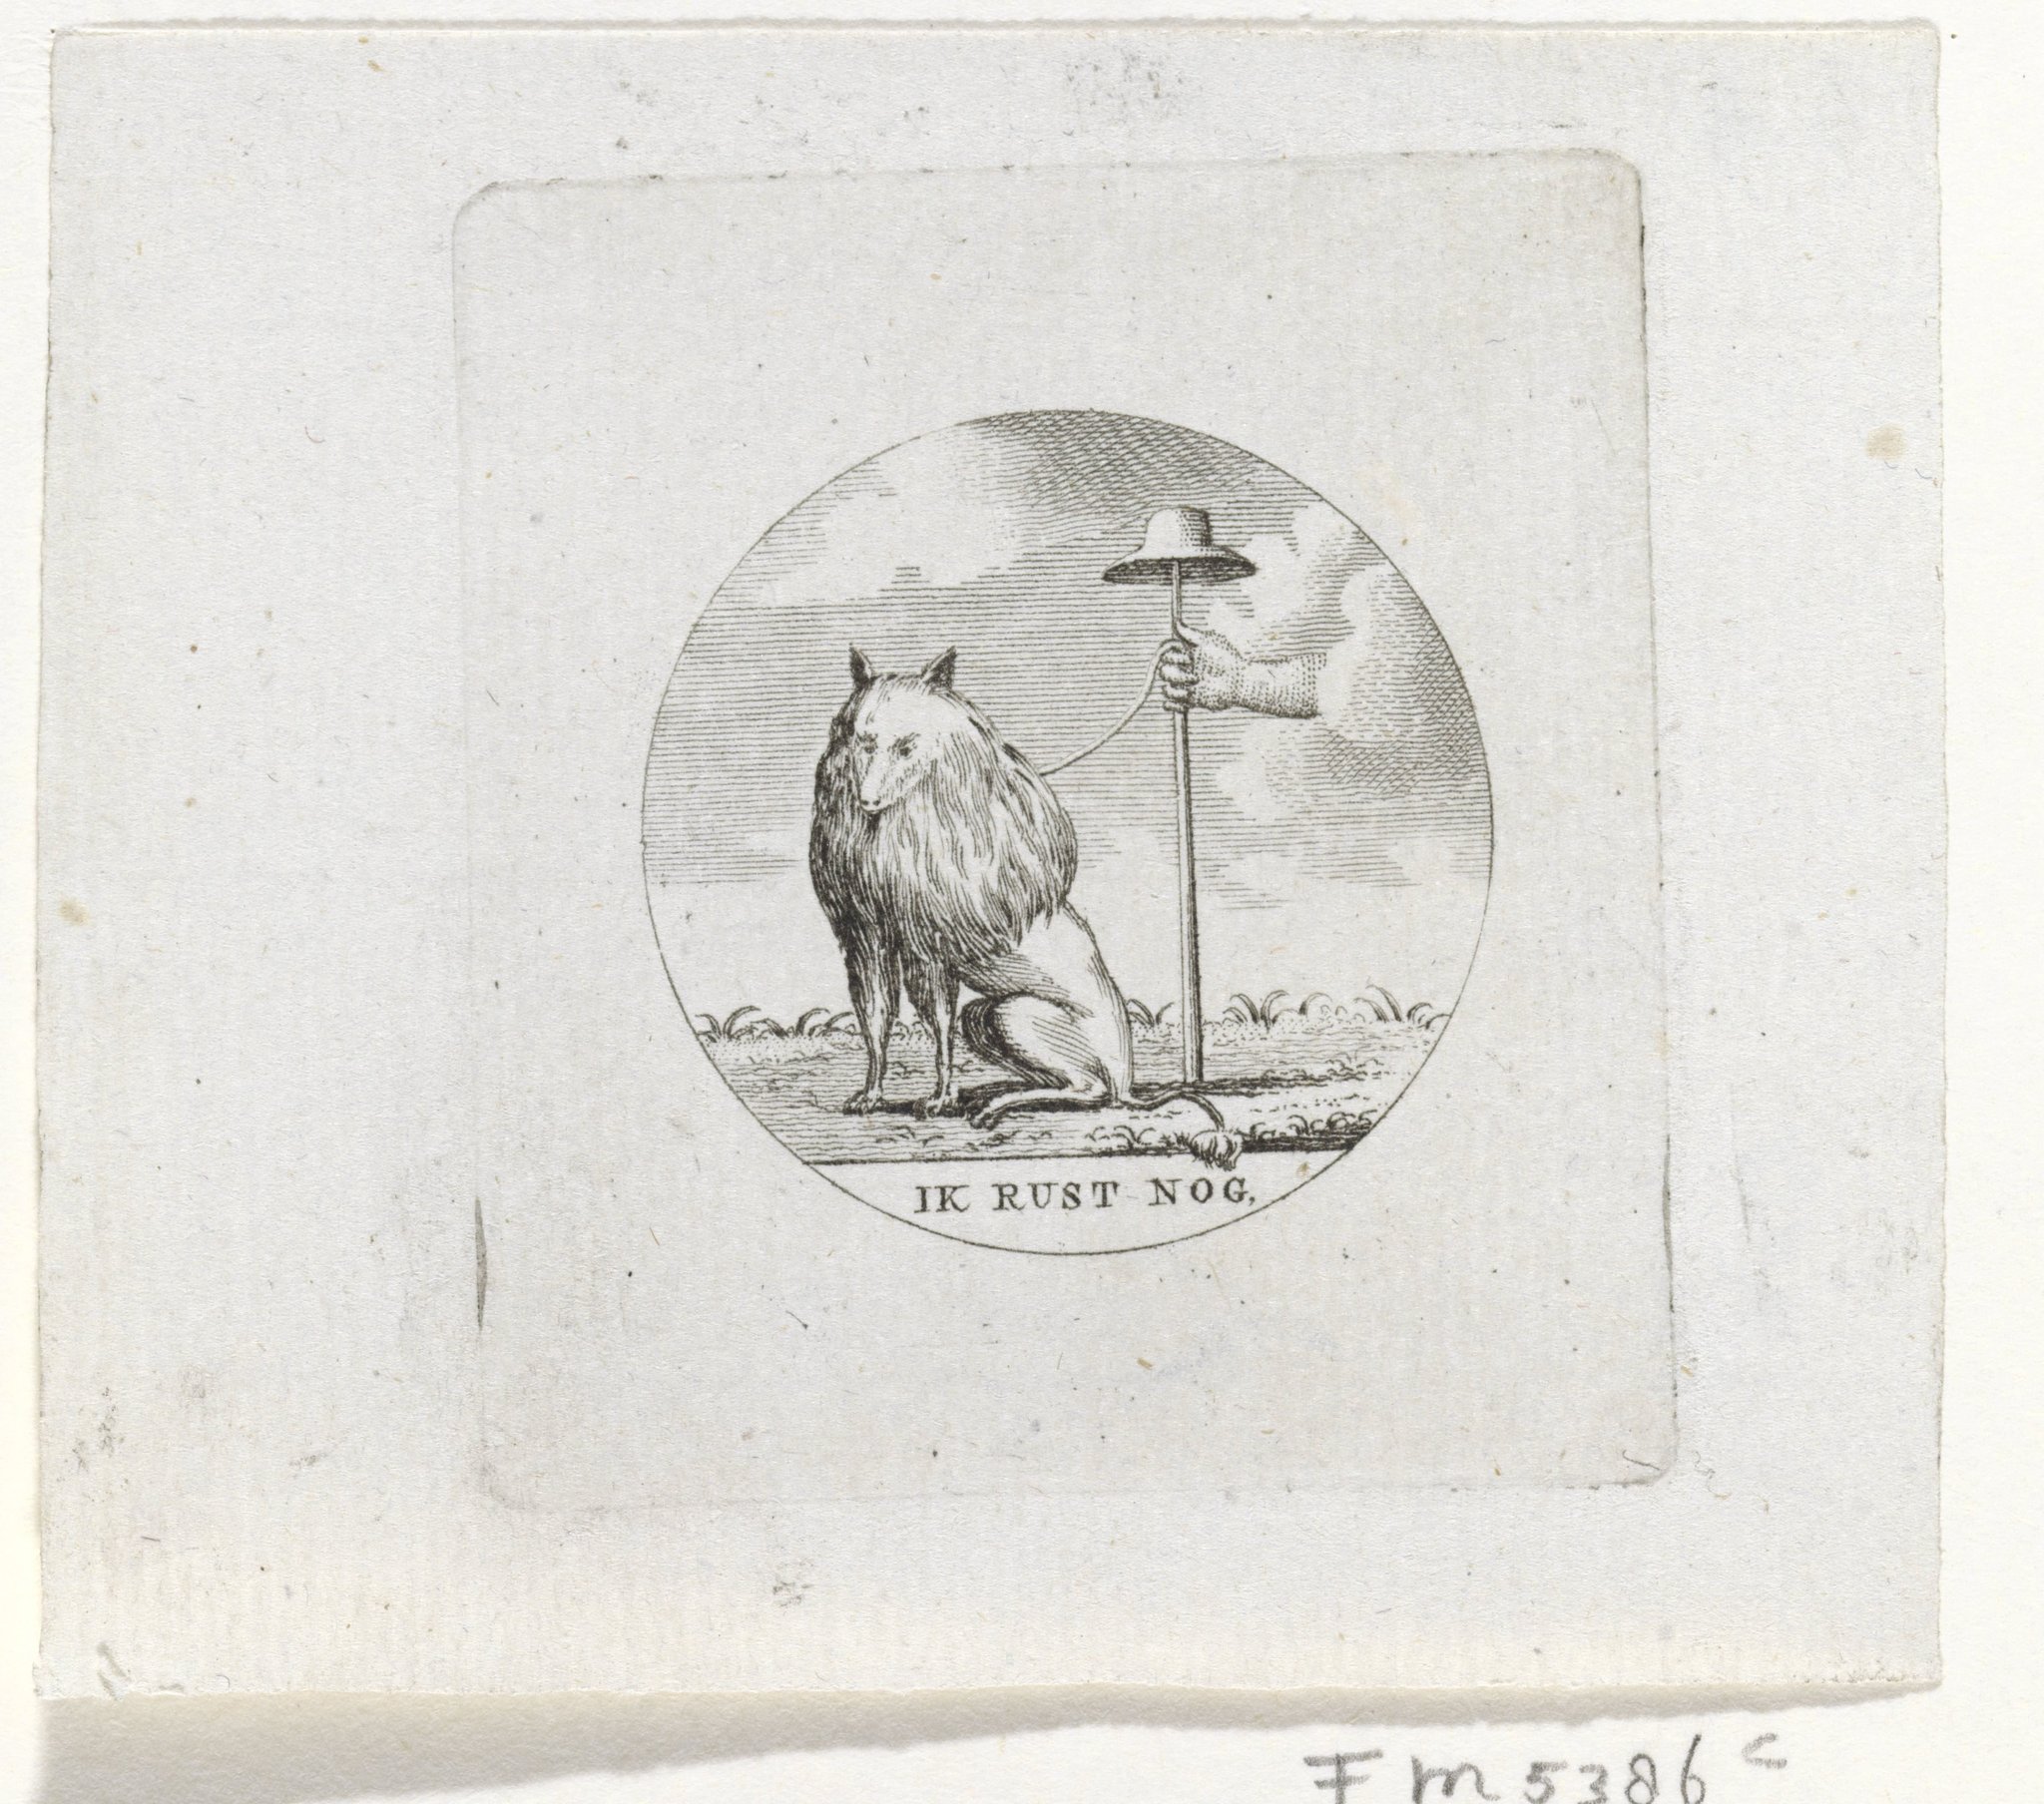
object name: print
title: Ik rust nog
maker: Anonymous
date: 1787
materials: paper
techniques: engraving, etching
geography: netherlands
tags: dog, freedom, liberty; 'libertà' (ripa) (+ symbolical representation of concept), patriots (1780-1795)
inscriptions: collector's mark: Lugt 2228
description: Rond vignet met een zittende keeshond, aangelijnd aan de standaard met vrijheidshoed vastgehouden door een hand uit de wolken. Waarschijnlijk rond 1787, toen de patriotten na het herstel van de stadhouder het land ontvlucht waren.